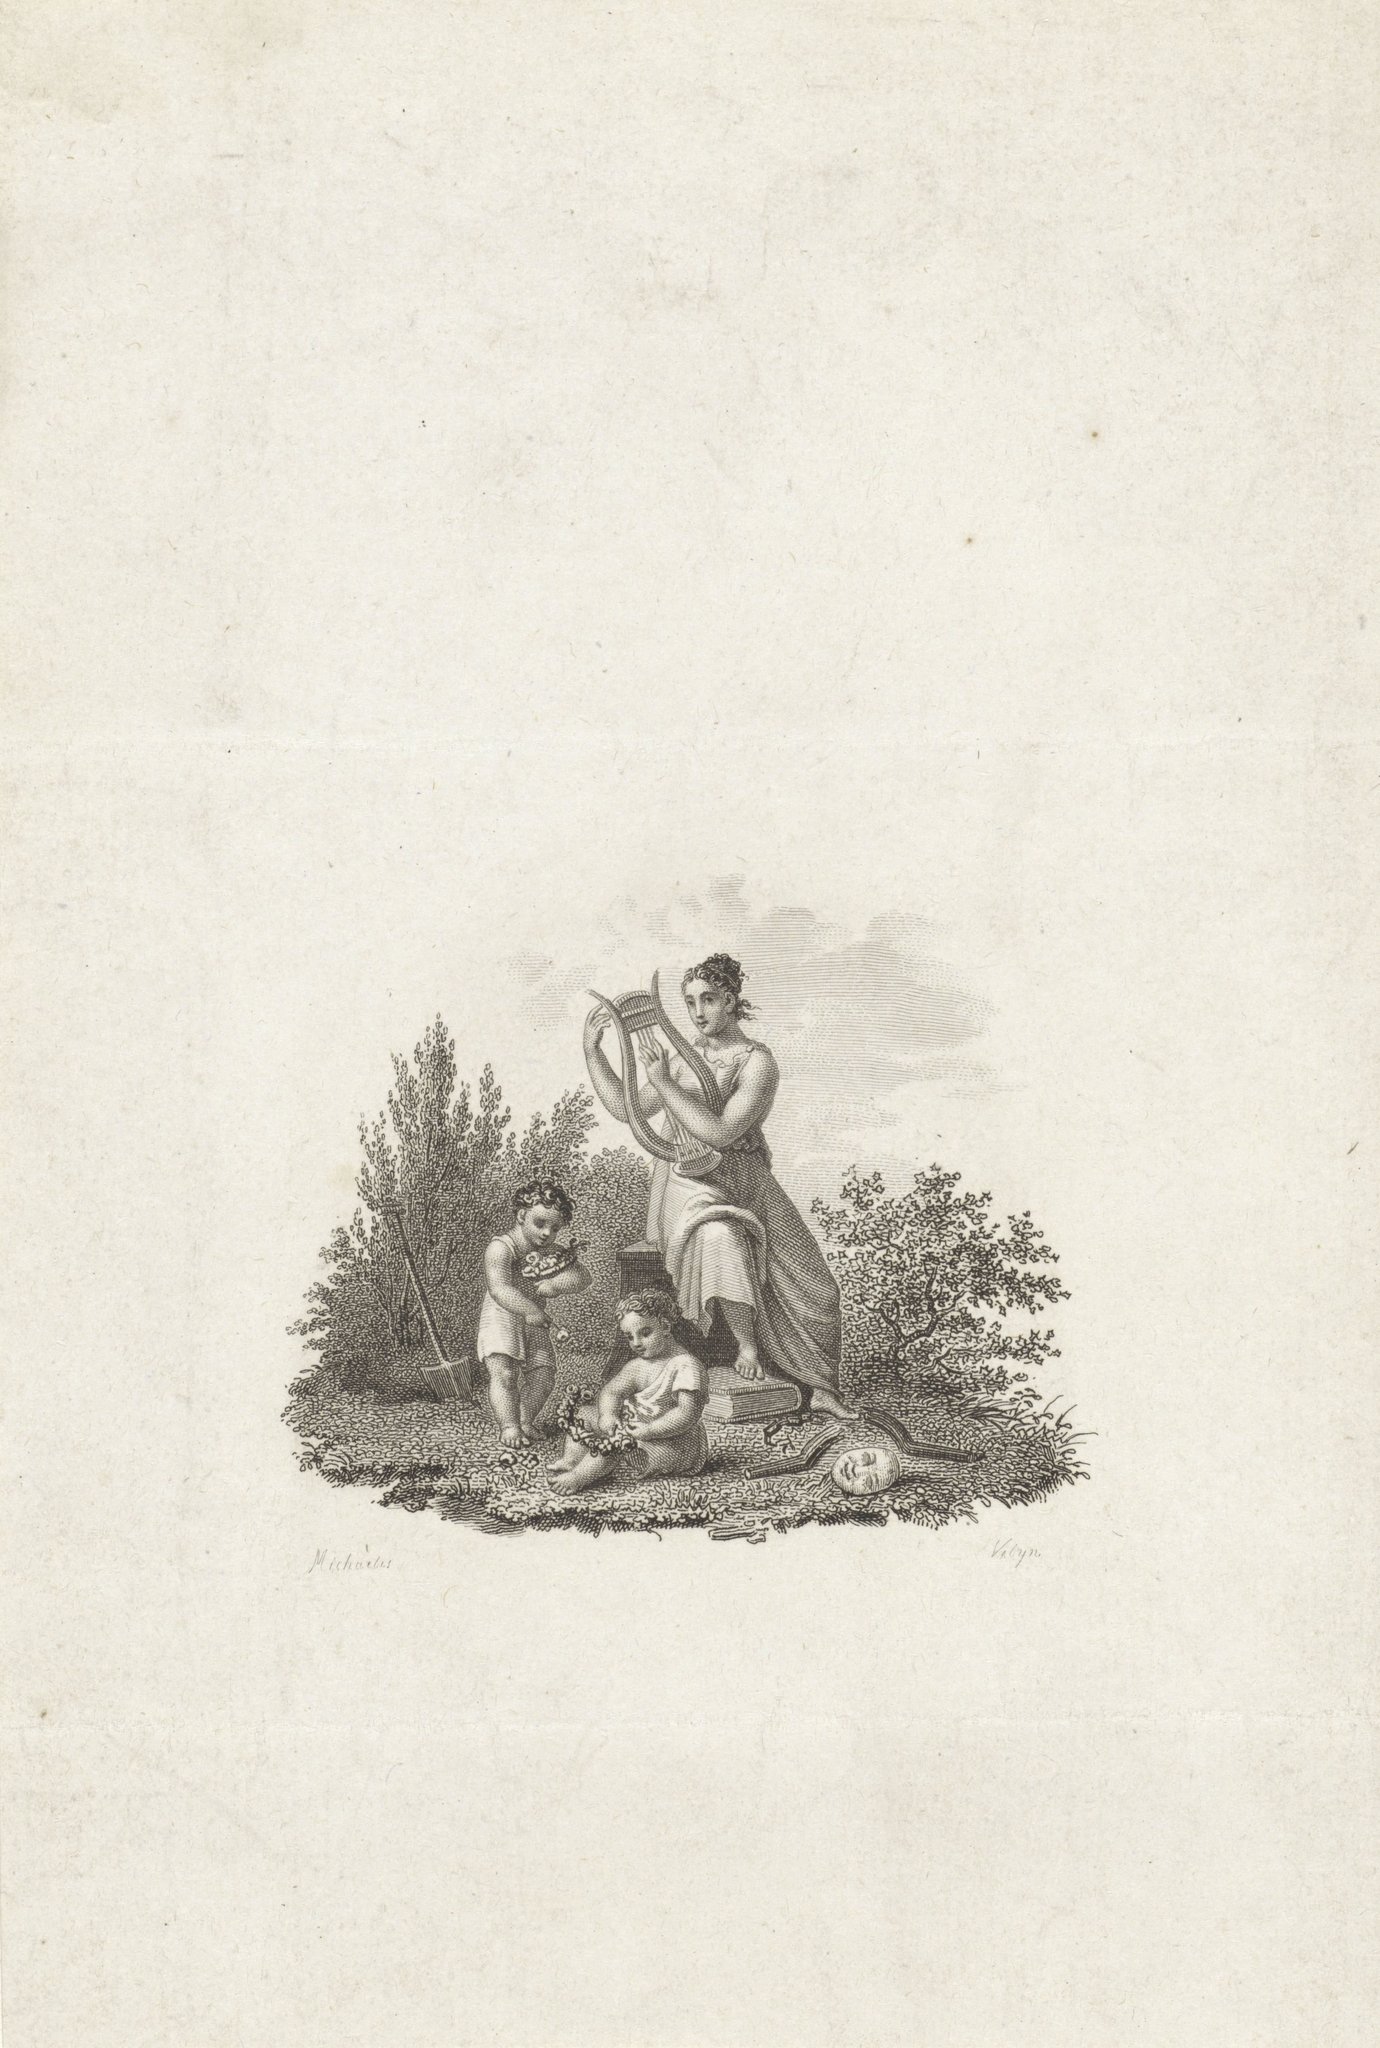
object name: print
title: Lierspelende vrouw en twee spelende kinderen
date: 1822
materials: paper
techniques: engraving, etching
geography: netherlands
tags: flowers, mask, lyre, cithara, psaltery, yoke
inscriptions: collector's mark: Lugt 2228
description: Een lierspelende vrouw en twee met bloemen spelende kinderen op de grond aan haar voeten. Op de voorgrond een masker en een gebroken juk.